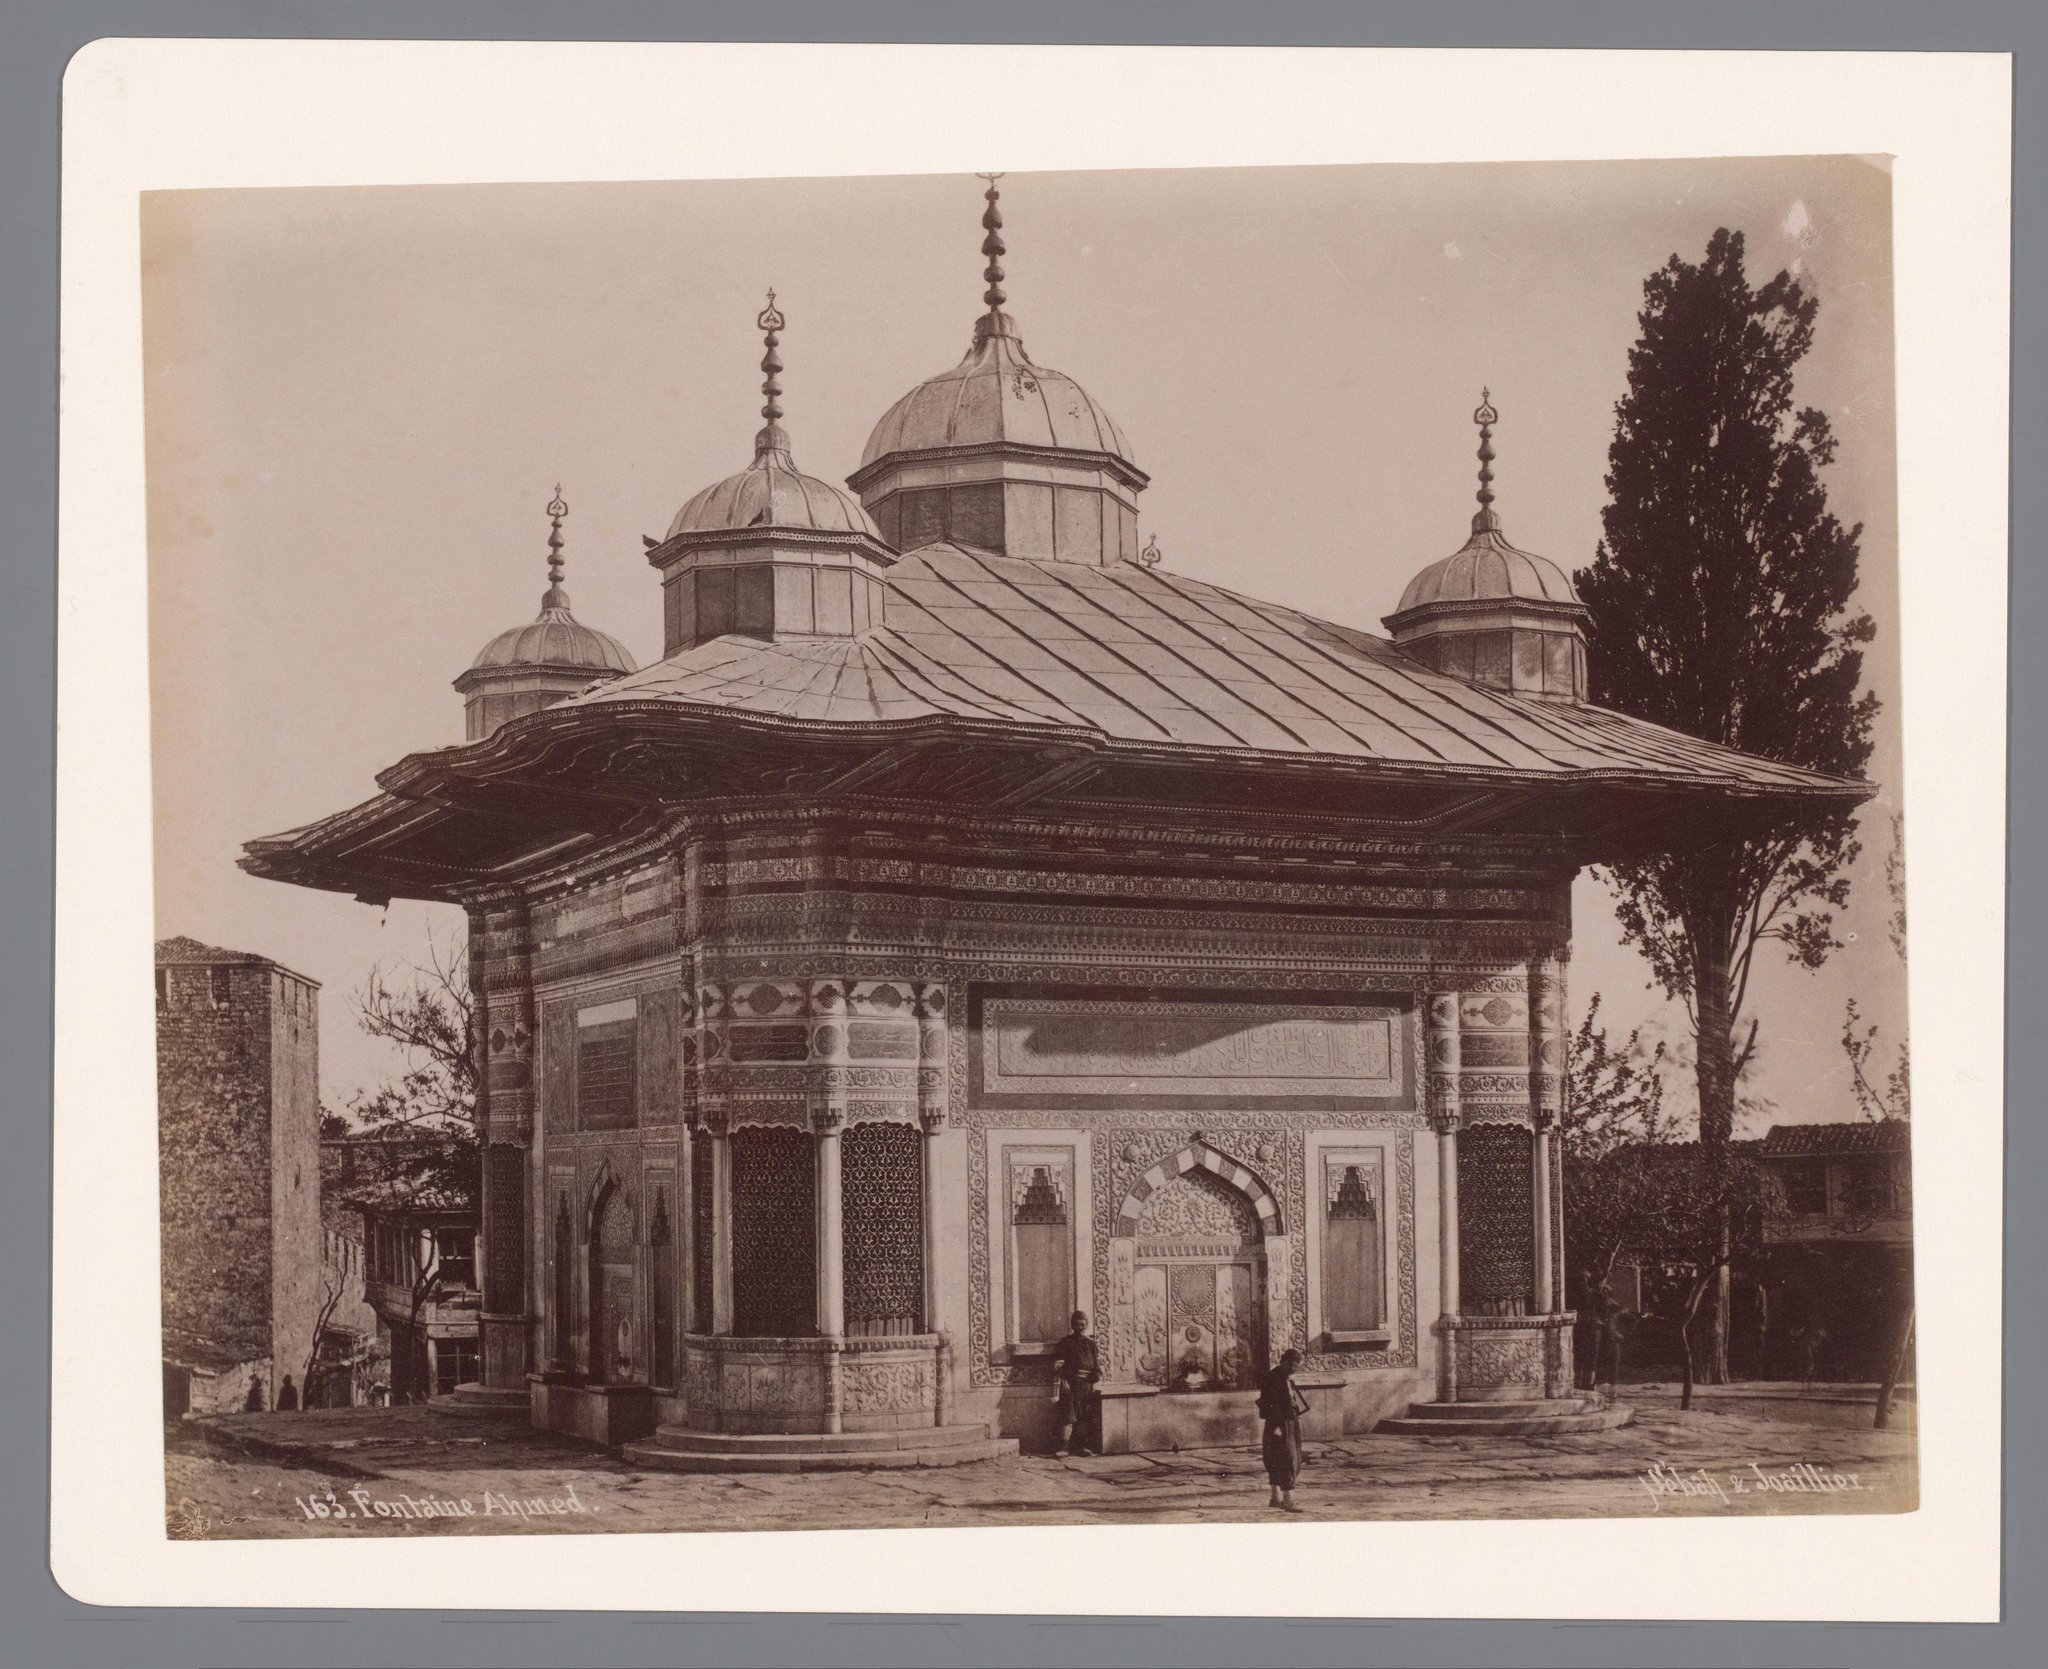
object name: photograph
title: Fontein van sultan Ahmed III in Istanboel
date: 1888-1900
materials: paper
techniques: albumen print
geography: istanbul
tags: utilitarian, public pump or water fountain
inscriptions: number: ‘163.’